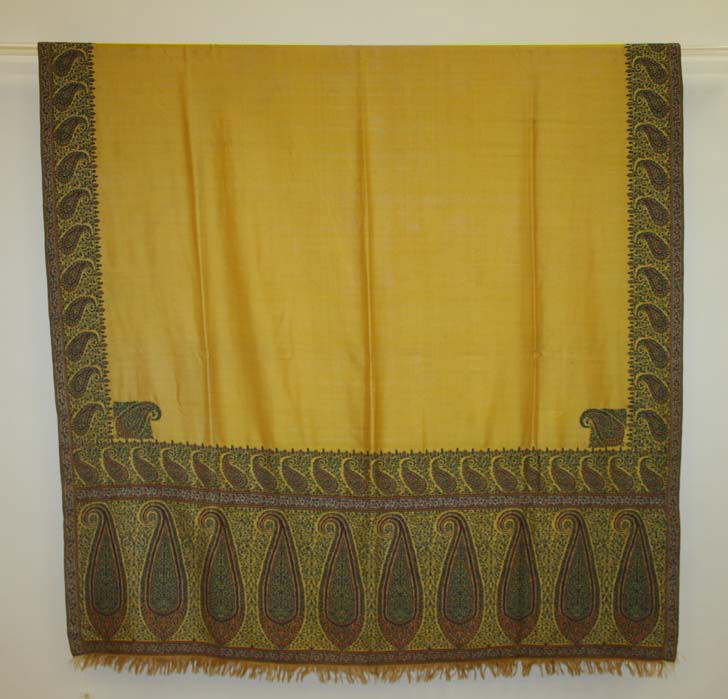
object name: shawl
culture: french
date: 1801-1900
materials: silk, wool